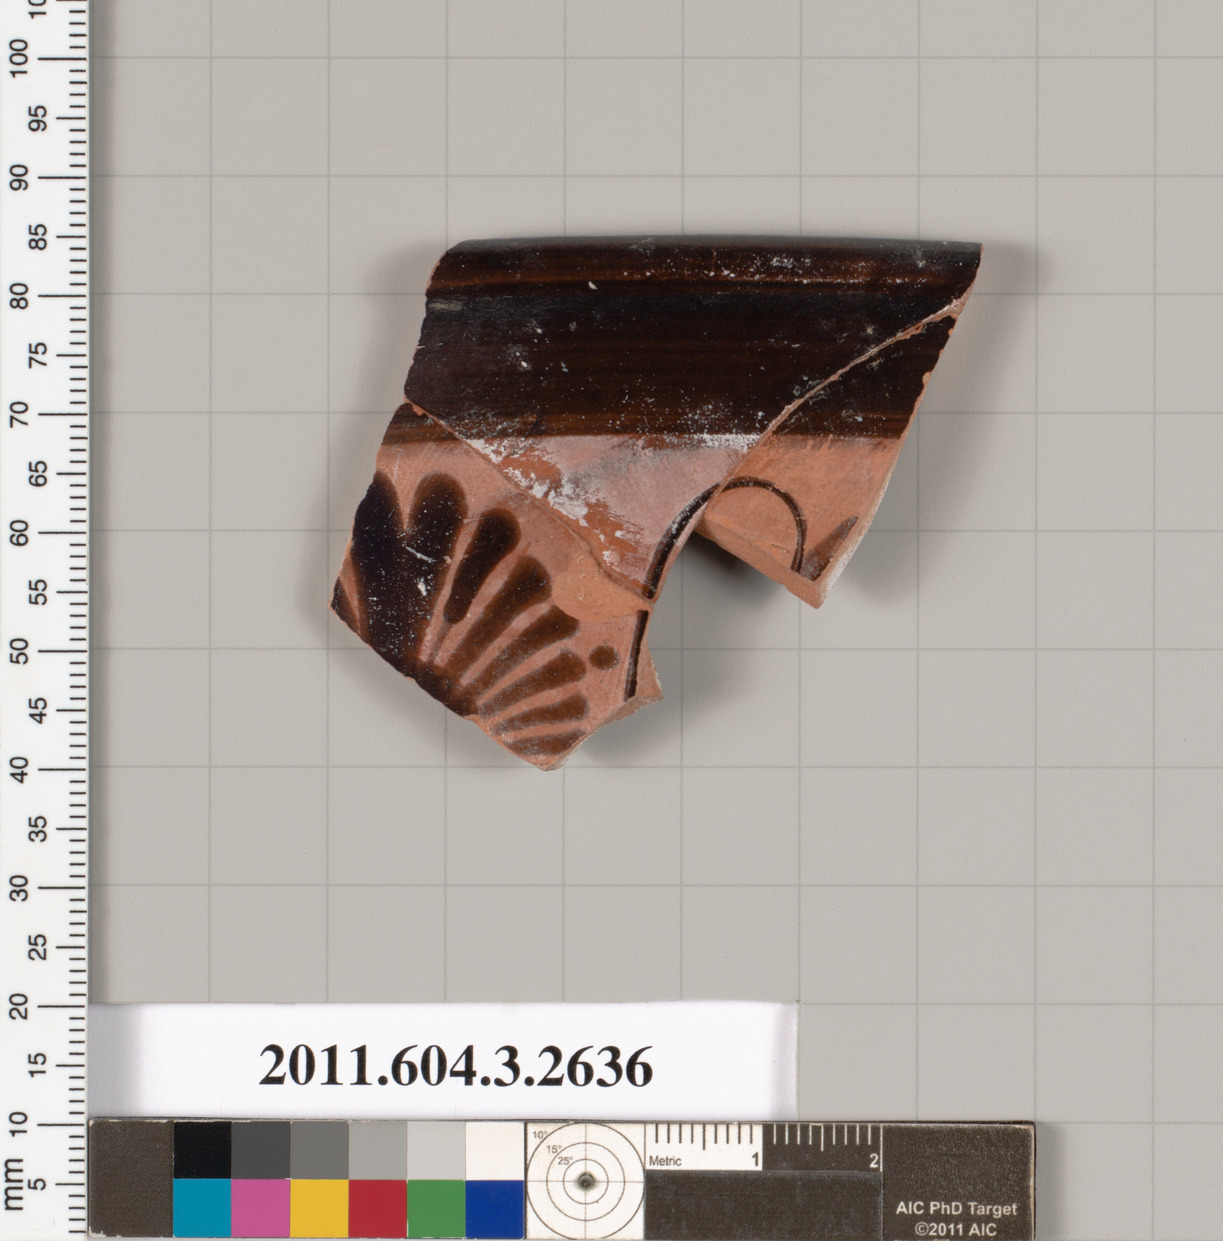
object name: skyphos fragment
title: Terracotta rim fragment of a skyphos (deep drinking cup)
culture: greek, attic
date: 534-501 BCE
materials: terracotta